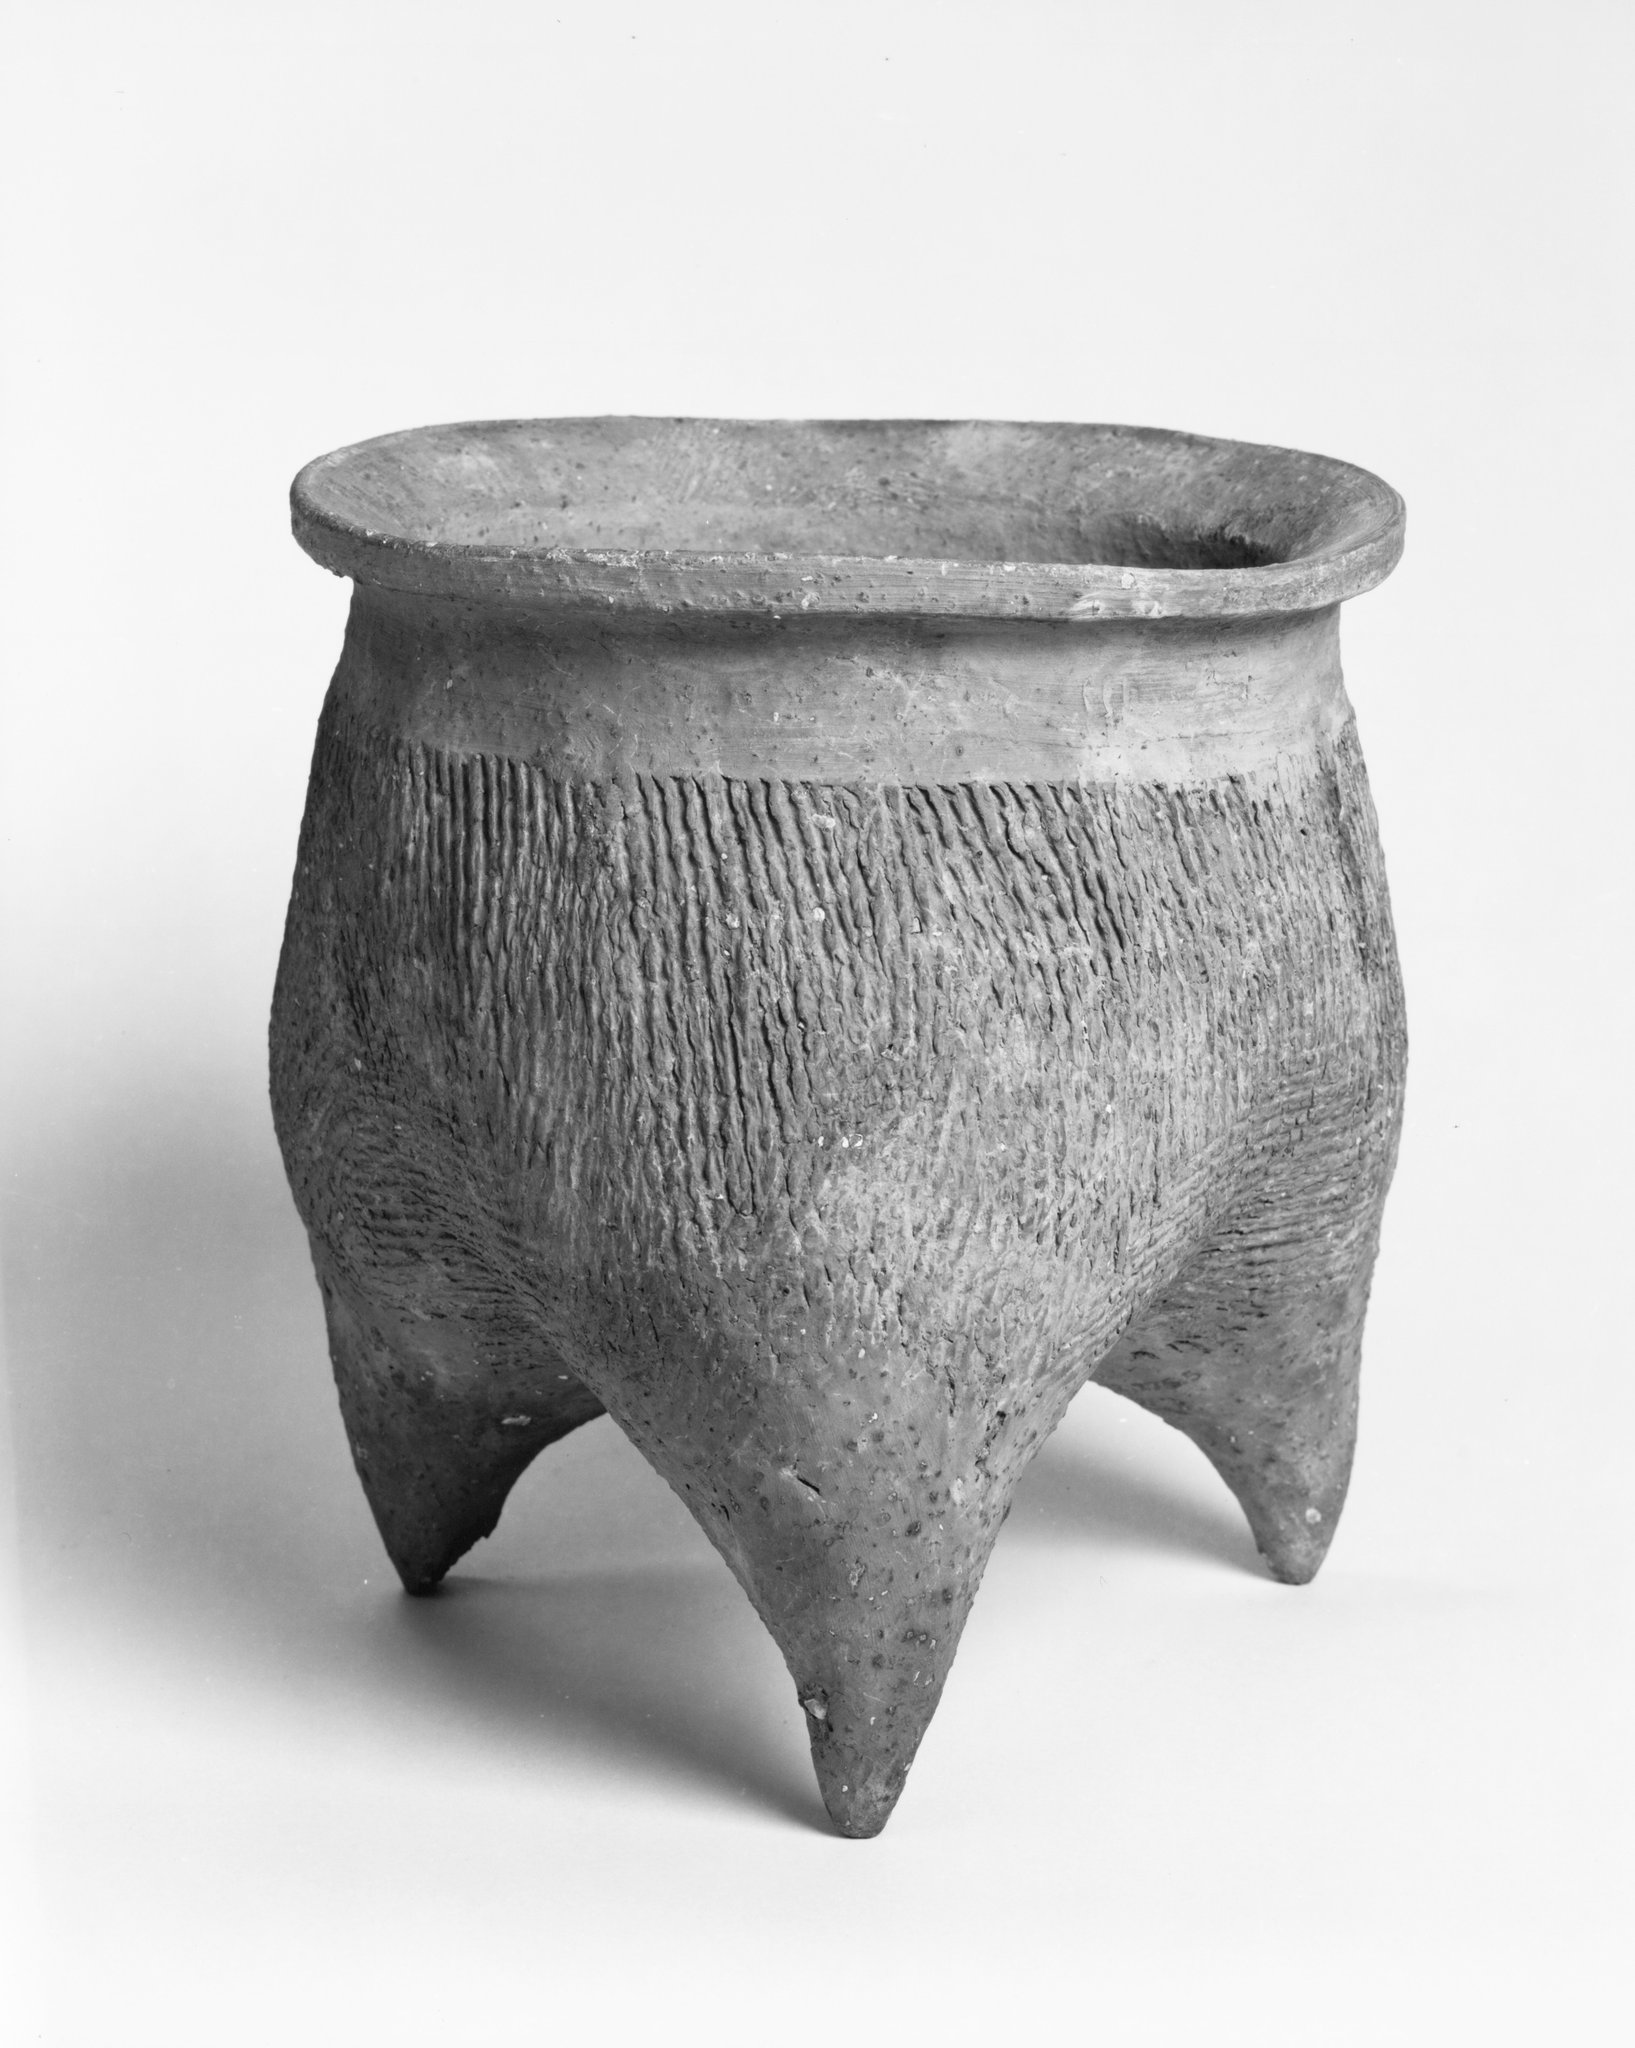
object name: cooking vessel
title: Lobed cooking cauldron (Li )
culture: chinese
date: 1200-1001 BCE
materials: earthenware